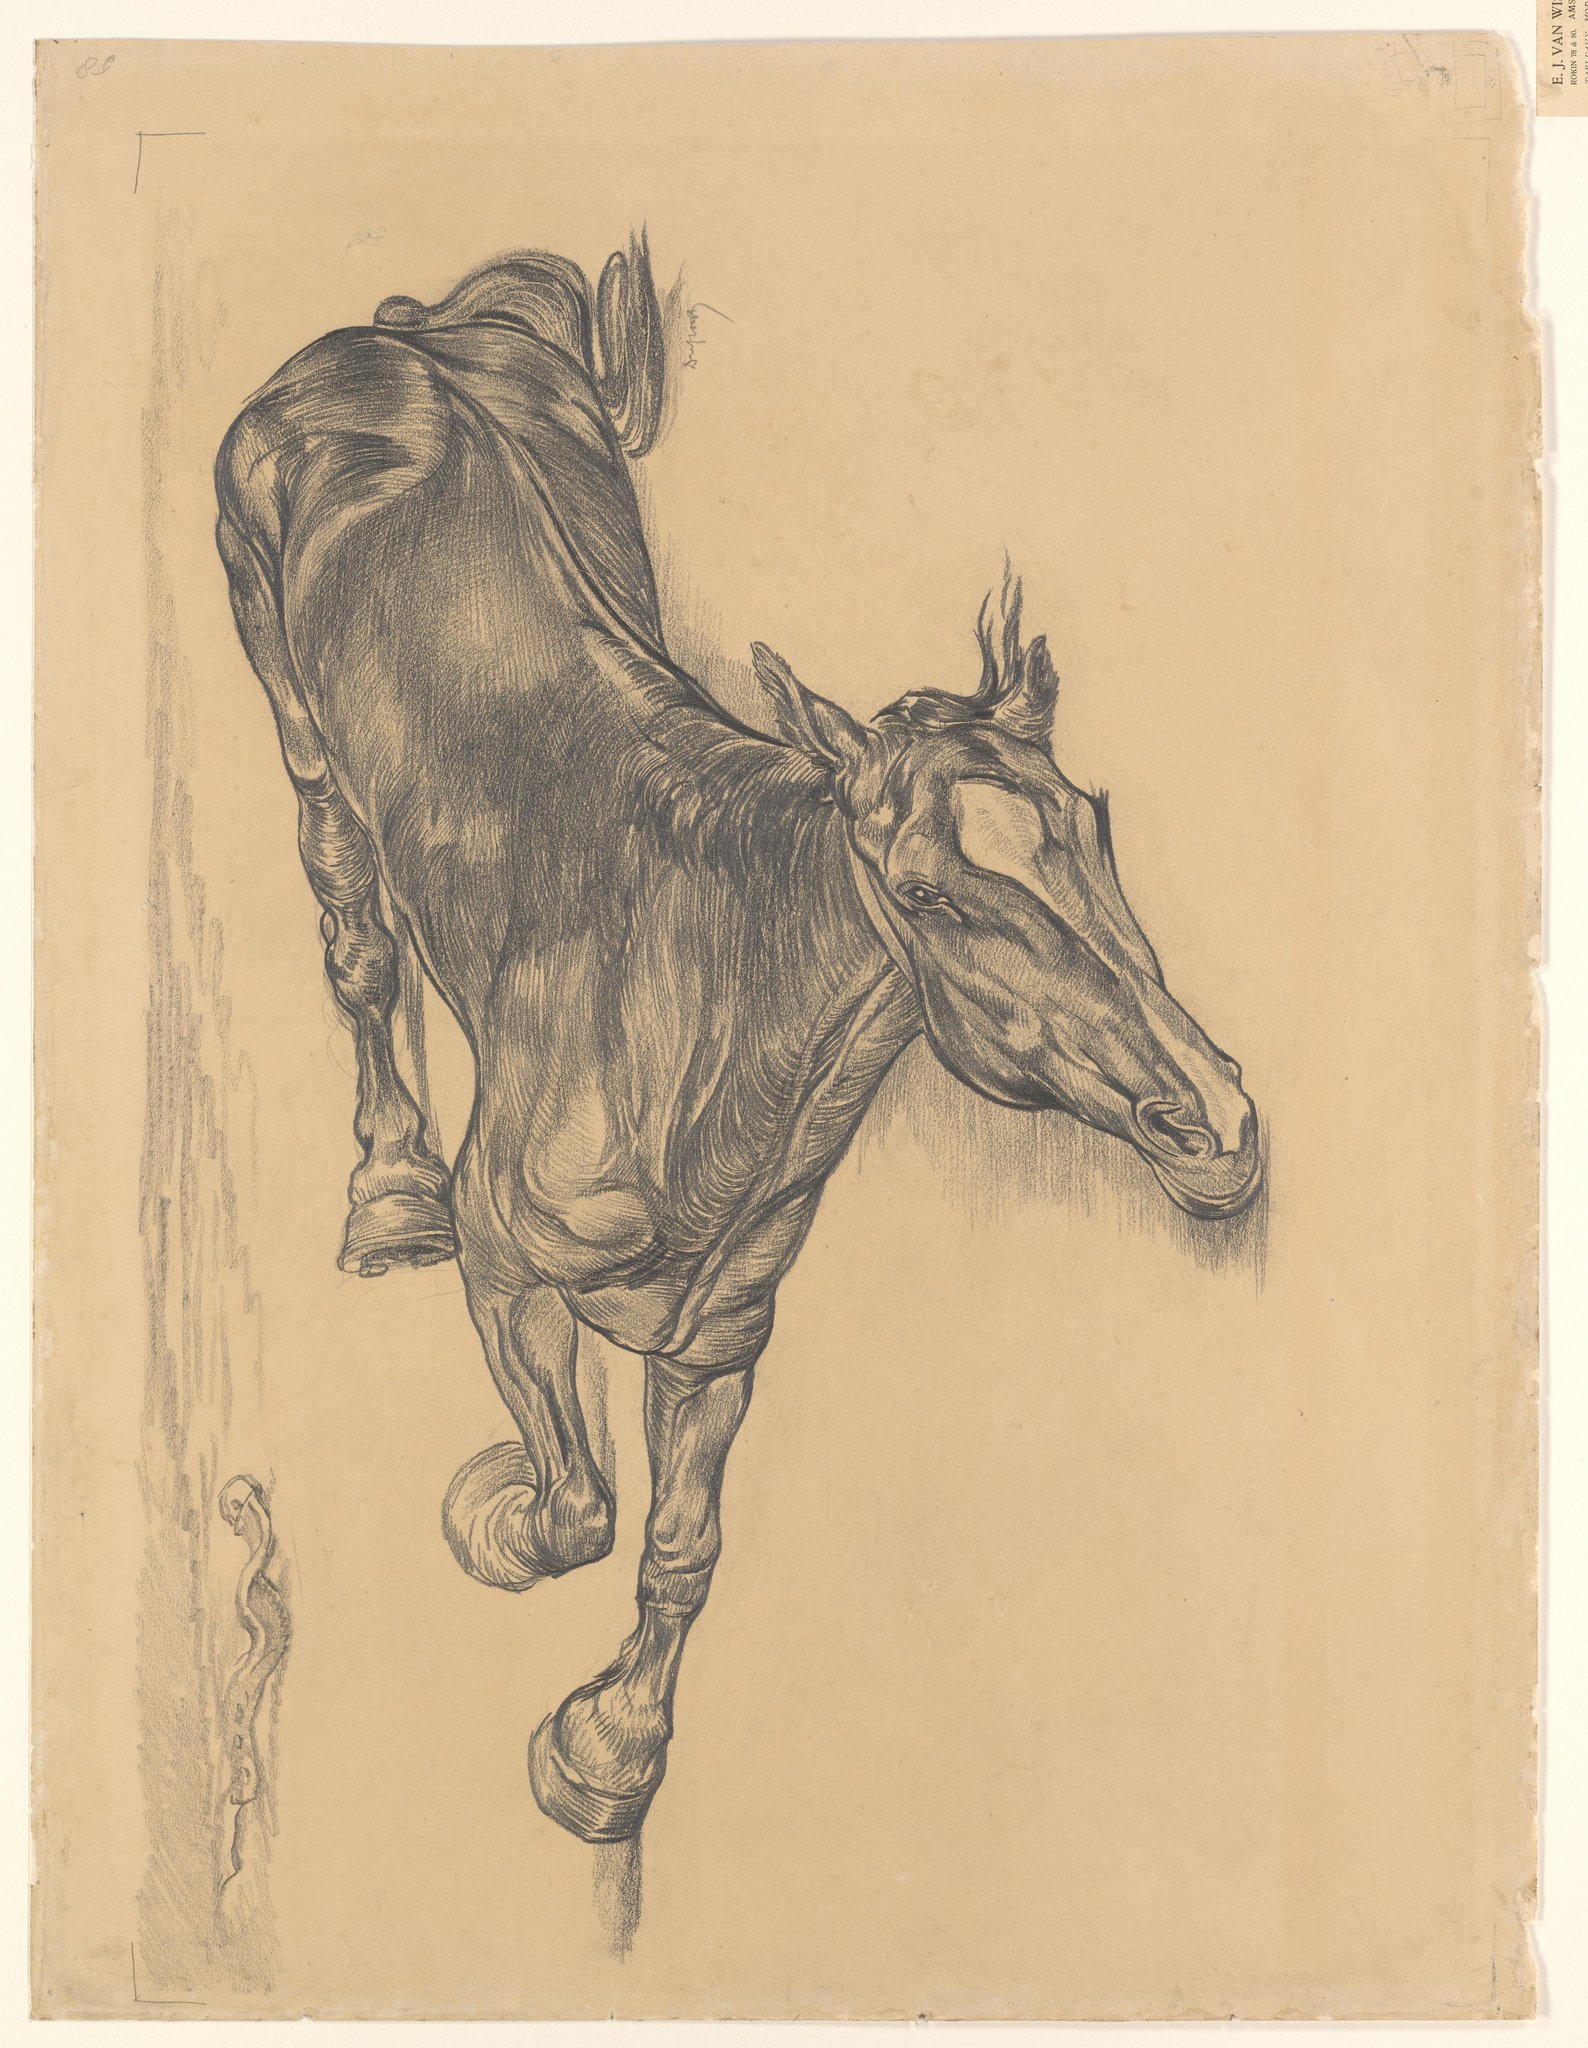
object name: drawing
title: Dood paard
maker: pieter dupont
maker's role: draughtsman, print maker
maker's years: 1870-1911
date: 1880-1911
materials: paper, pencil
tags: horse (+ dying animal; death of animal; dead animal)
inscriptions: label: ‘E.J. van Wisselingh & Co./ Rokin 78 & 80. Amsterdam. Telefoon 4448./ Tableaux modernes, aquarelles (...)’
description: Naast het paard ligt een deel van een riem.